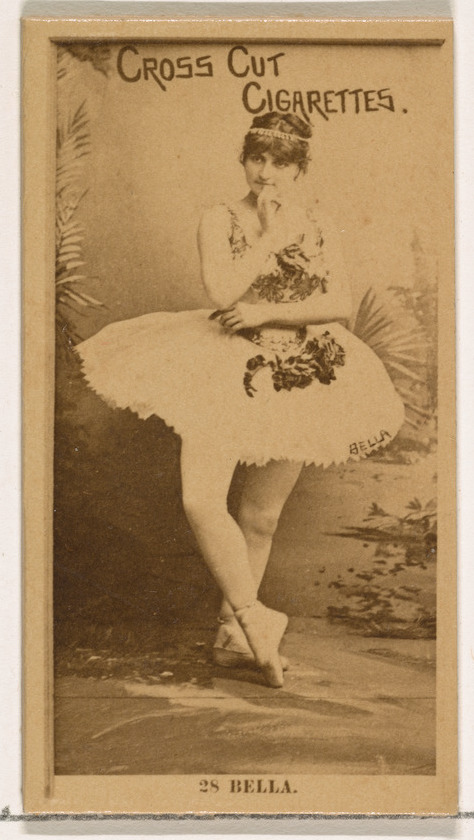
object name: print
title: Card Number 28, Bella, from the Actors and Actresses series (N145-2) issued by Duke Sons & Co. to promote Cross Cut Cigarettes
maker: w. duke, sons & co.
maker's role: publisher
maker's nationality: american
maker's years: 1870-1920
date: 1880-1889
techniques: albumen silver print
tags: portraits,women,actresses